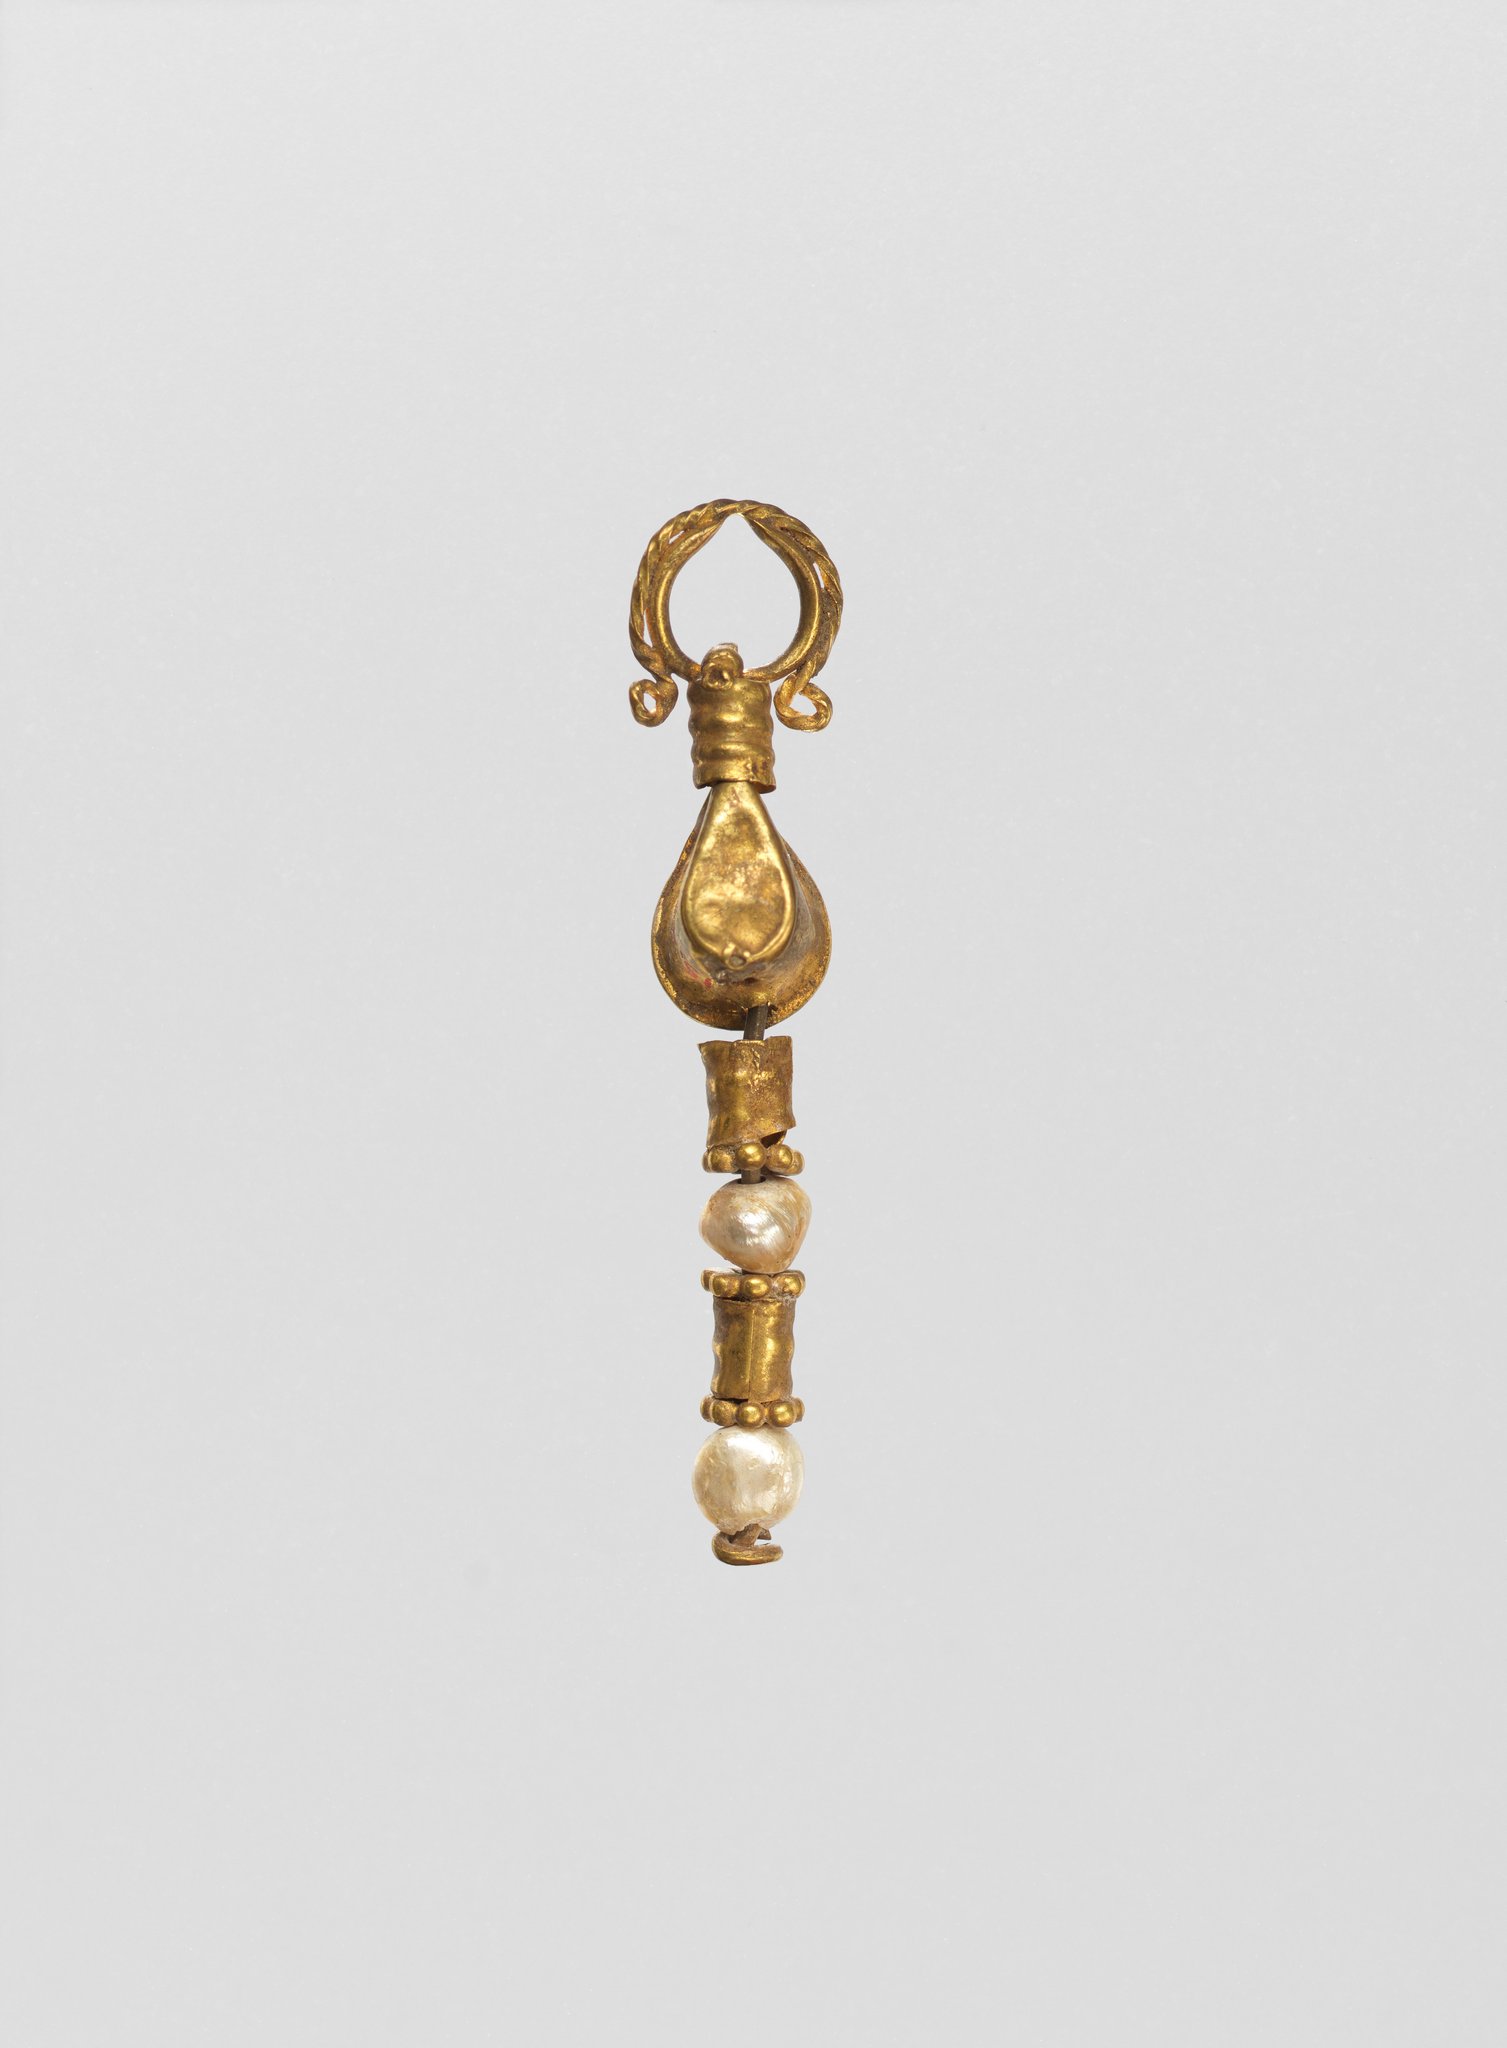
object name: earring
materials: gold, pearl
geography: egypt